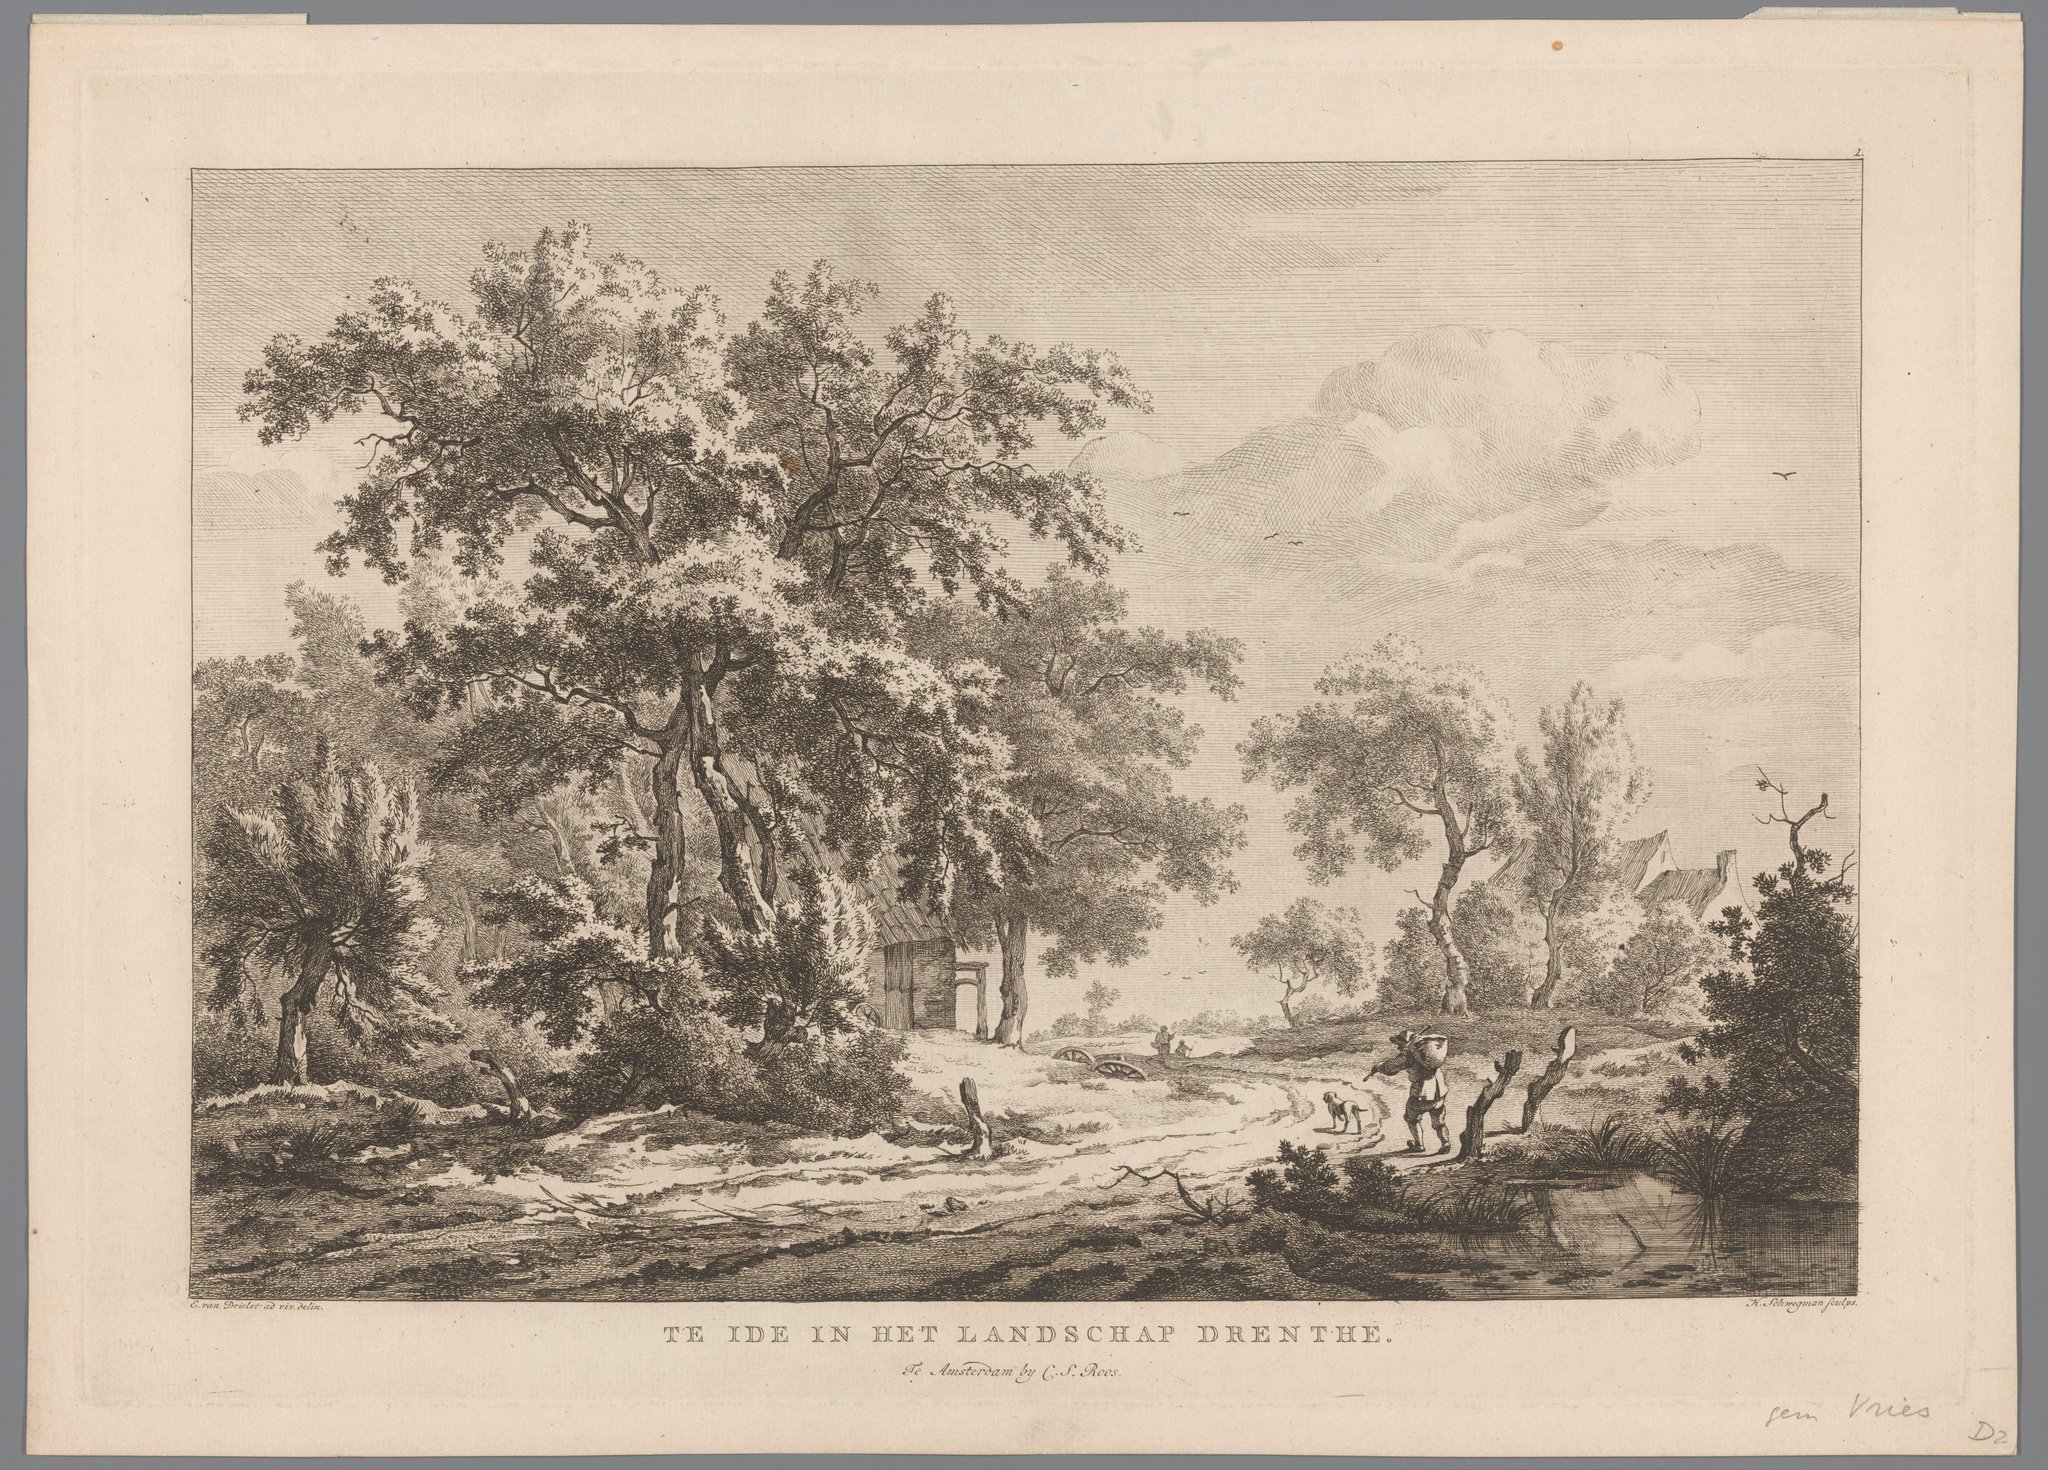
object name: print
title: Negen gezichten in Drenthe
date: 1794-1800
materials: paper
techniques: etching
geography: haarlem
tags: road, path, landscapes in the temperate zone (+ landscape with figures, staffage)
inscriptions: collector's mark: Lugt 2228